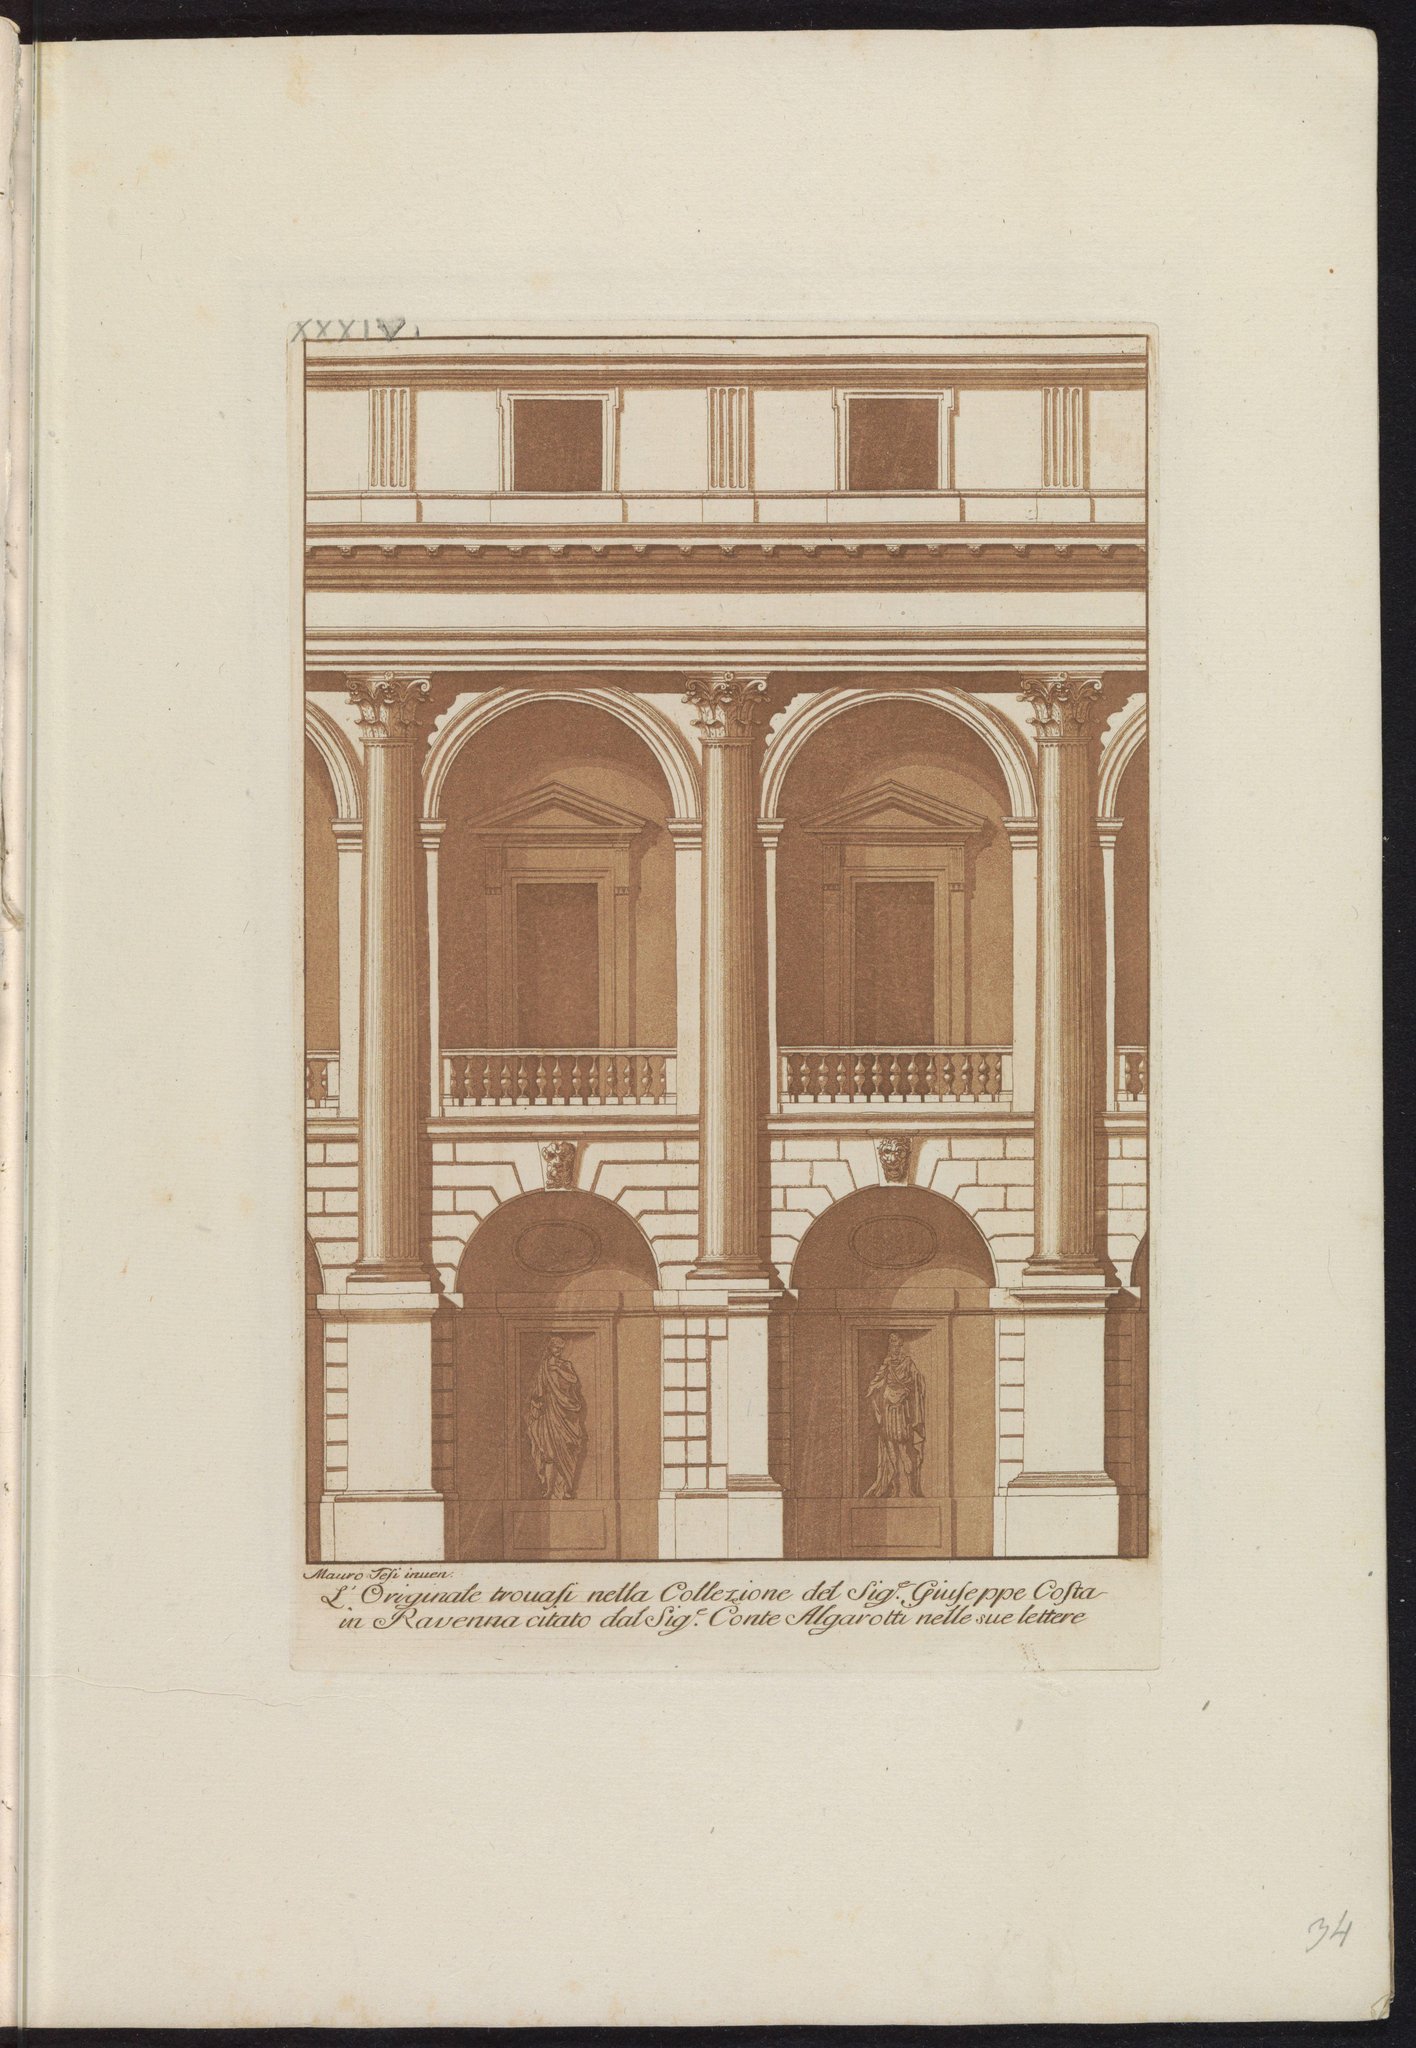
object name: album leaf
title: Frontaal aanzicht op twee traveeën met beeldhouwwerken in nissen op de grond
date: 1787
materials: paper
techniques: aquatint, etching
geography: bologna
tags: piece of sculpture, reproduction of a piece of sculpture